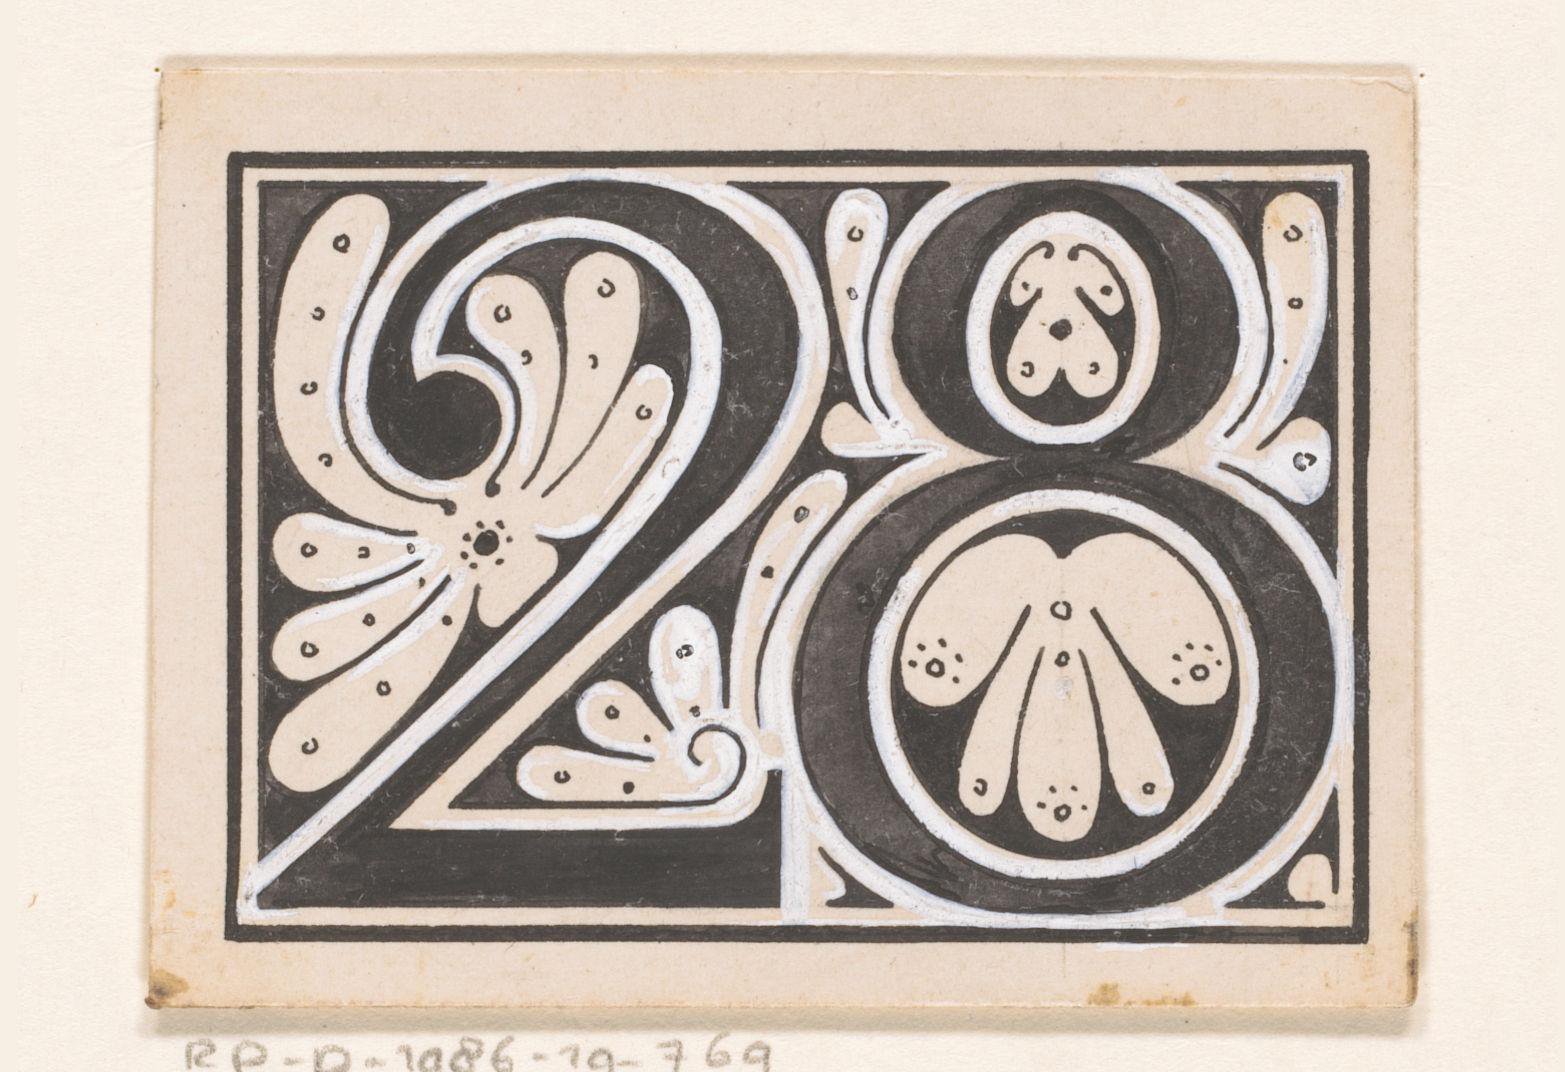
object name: design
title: Getal 28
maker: reinier willem petrus de vries (1874-1953)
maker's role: draughtsman, print maker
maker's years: 1874-1953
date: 1904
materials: paint, ink, paper, pencil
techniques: brush, pen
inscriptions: collector's mark: ‘R:MVS.’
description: Het getal is gebruikt voor: Veth, Jan. Jozef Israëls en zijn kunst. Arnhem en Nijmegen: Gebroeders E&M Cohen, 1904.